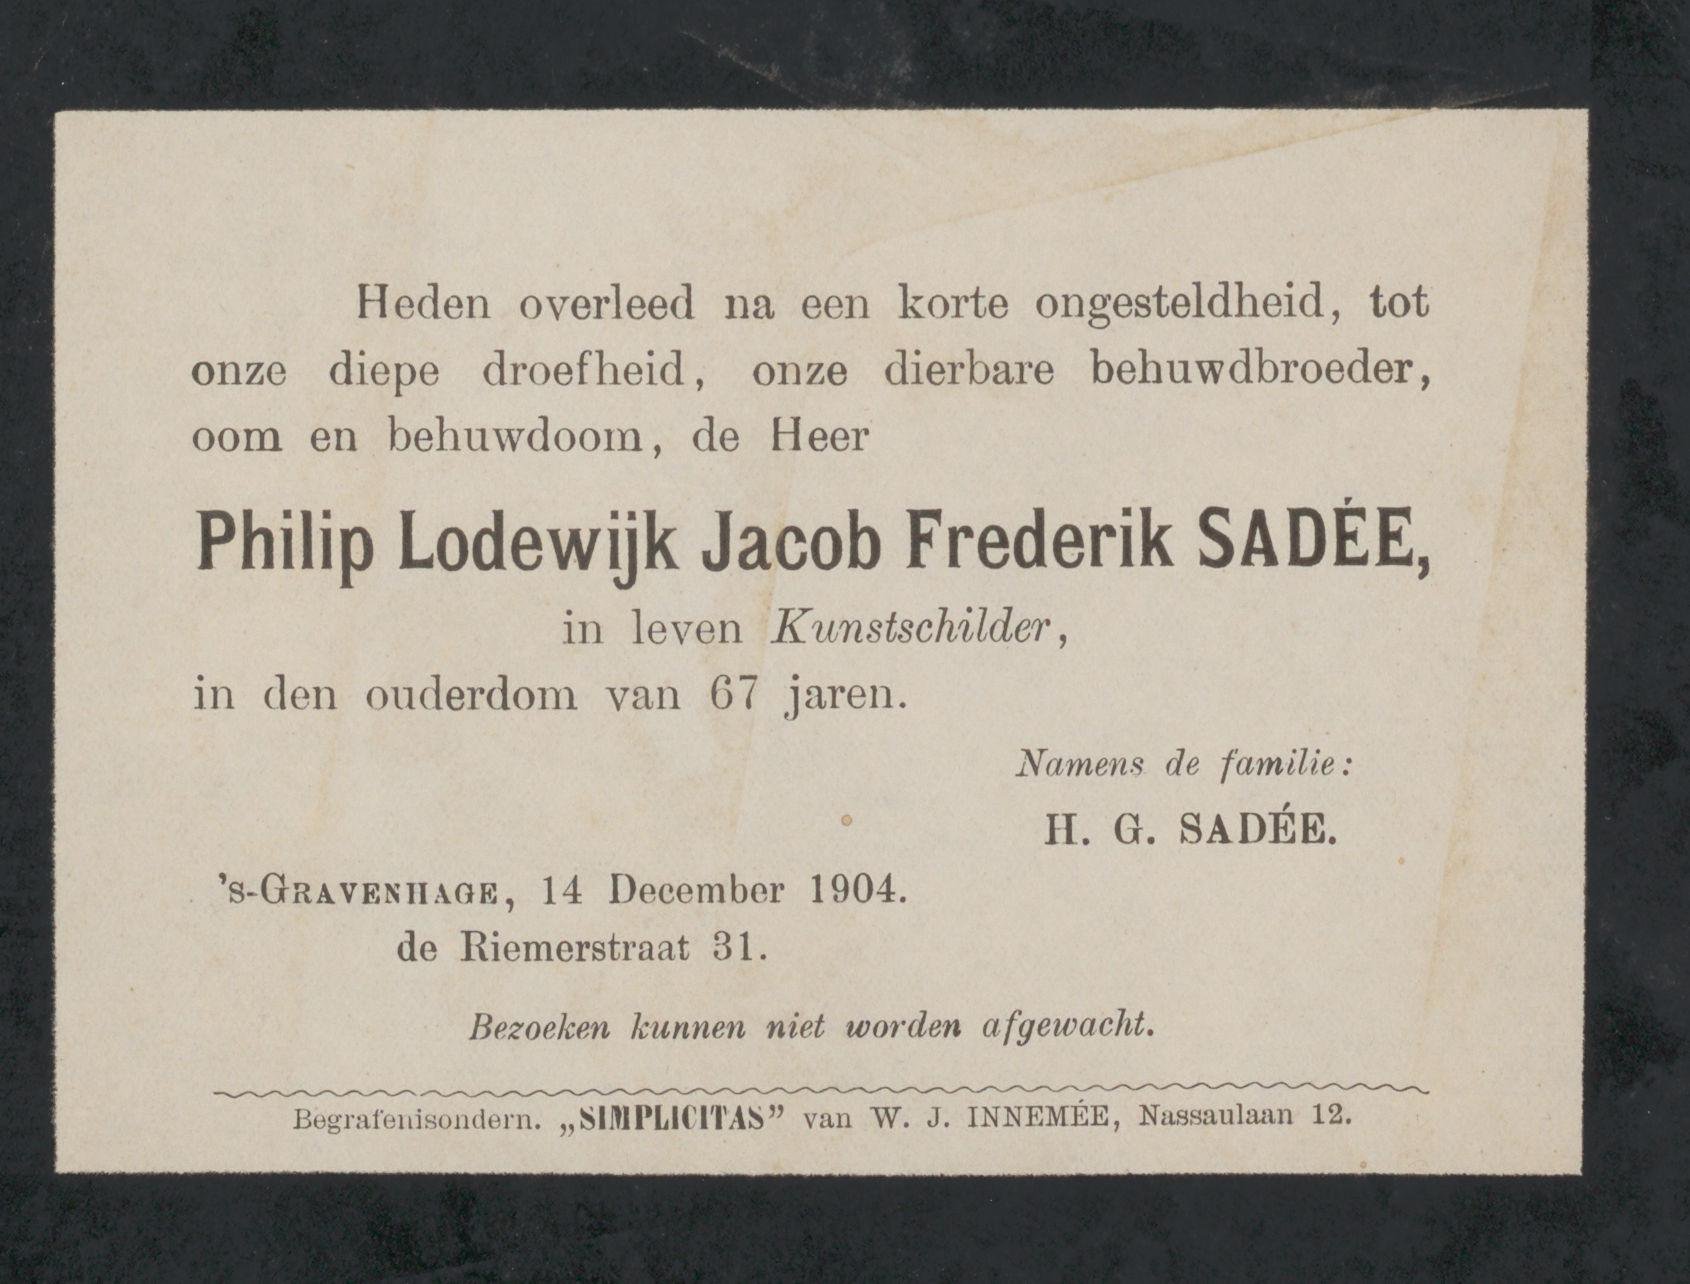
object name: overlijdensbericht, overlijdensadvertentie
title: Overlijdensbericht aan Philip Zilcken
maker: Anonymous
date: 1904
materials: paper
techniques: printing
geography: the hague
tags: the hague, painter, print maker, draughtsman, philip sadée, philip zilcken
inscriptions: collector's mark: ‘RPK’